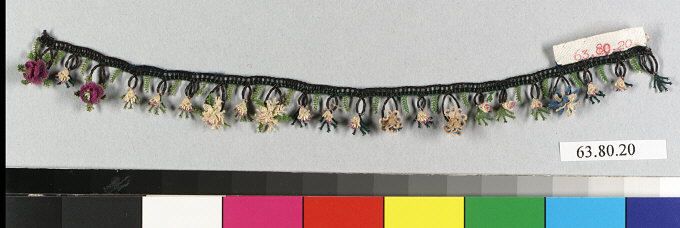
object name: piece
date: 1801-1900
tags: flowers